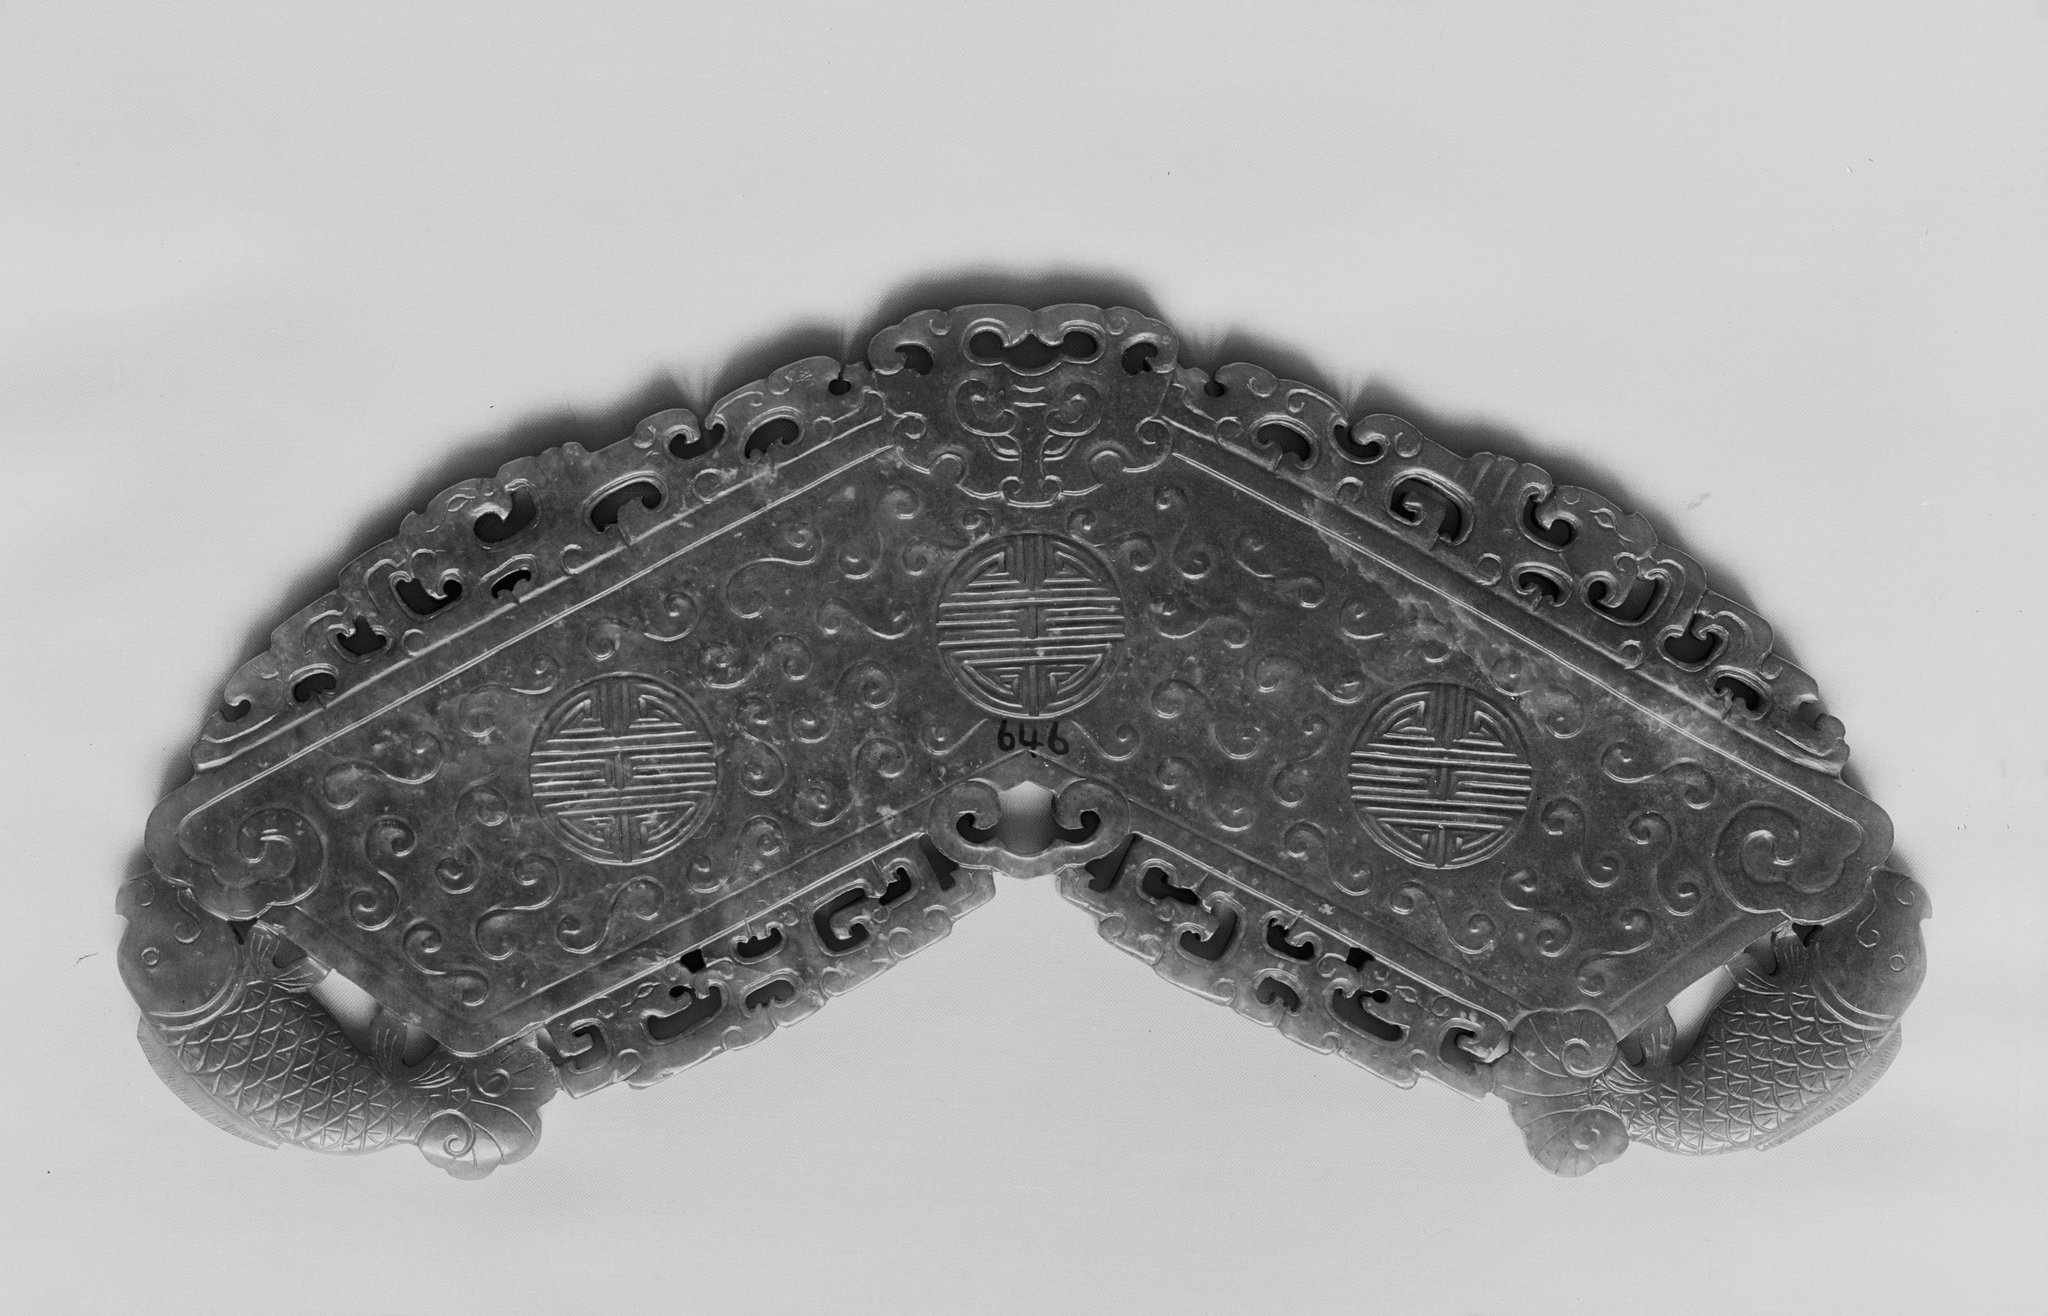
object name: musical stone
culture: chinese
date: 1736-1795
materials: jade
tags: musical instruments,fish